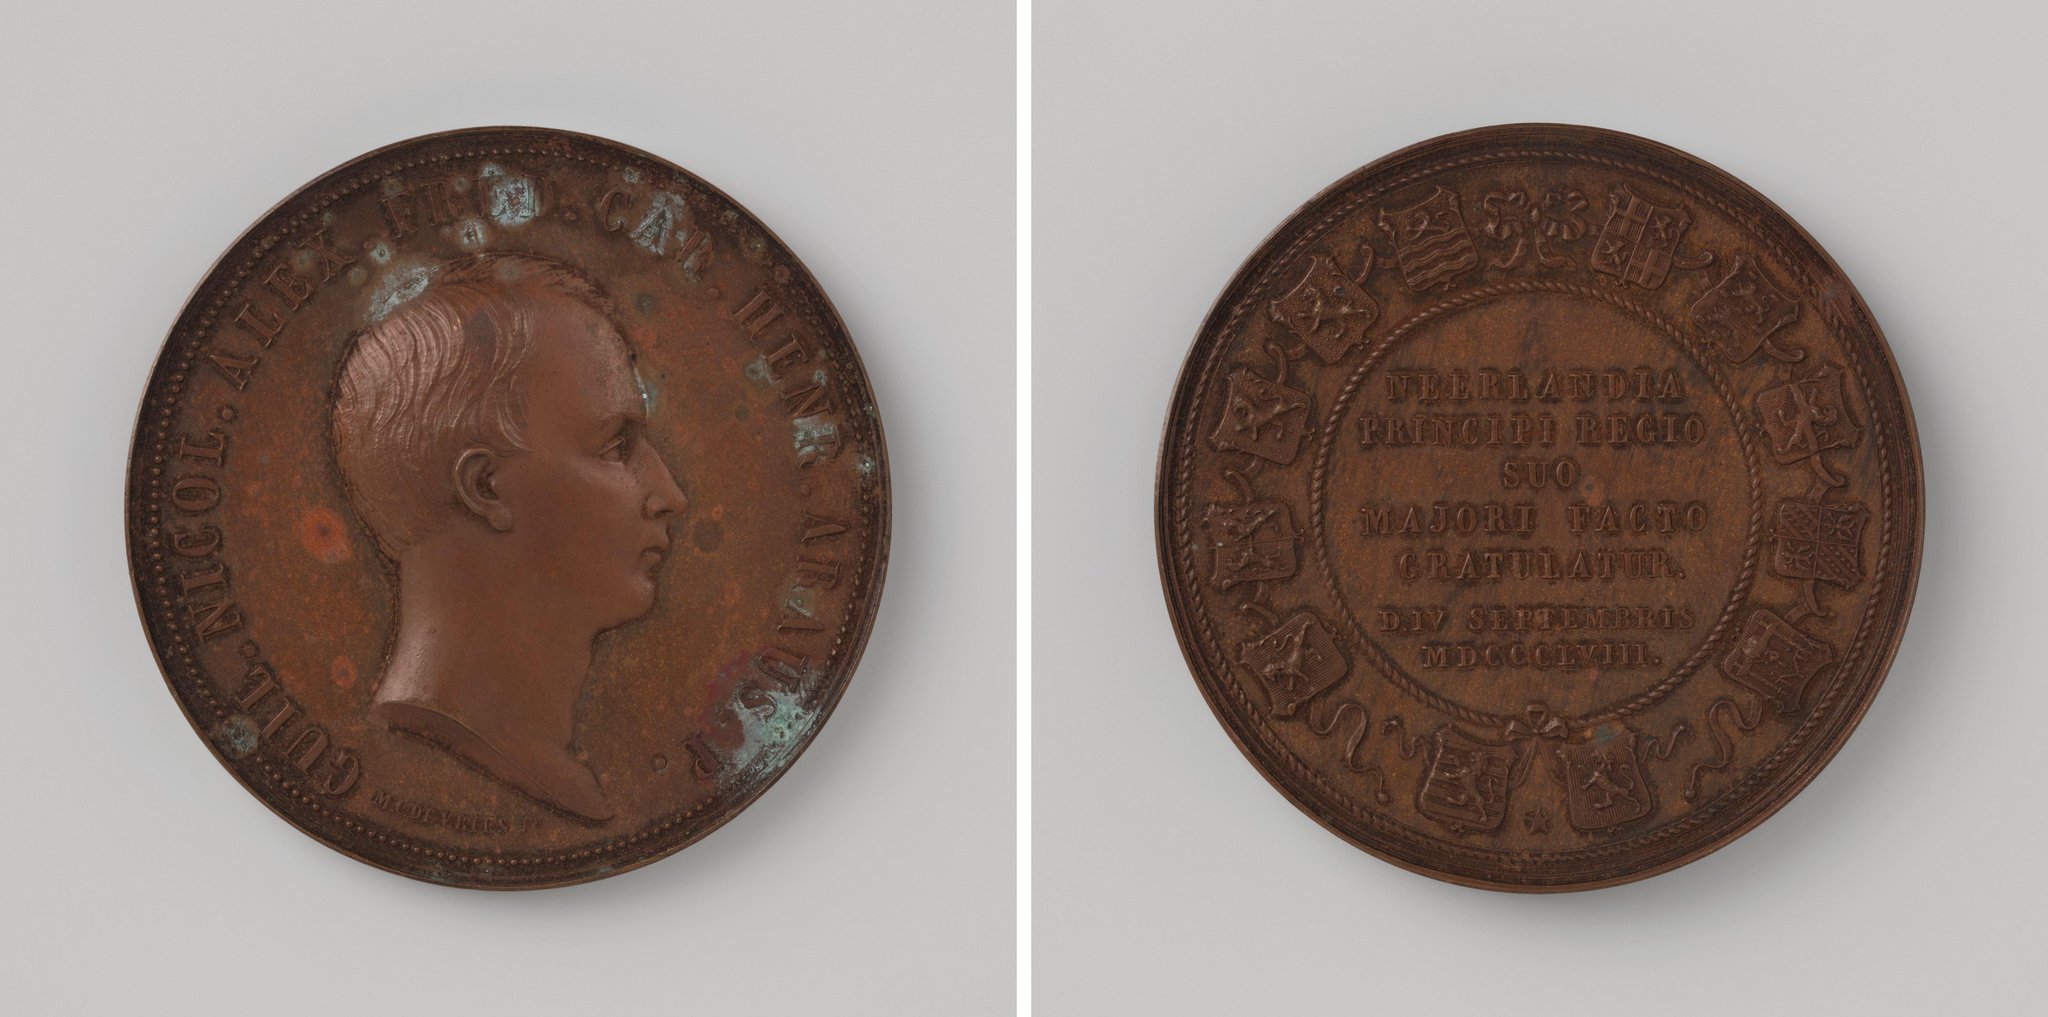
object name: history medal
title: Meerderjarigheid van kroonprins Willem Nicolaas Alexander 1858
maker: moses cohen de vries junior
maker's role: diamantslijper, graveur, medailleur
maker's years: 1807-1883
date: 1858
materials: bronze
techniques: striking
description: Bronzen penning, op de voorzijde het portret van de Kroonprins naar rechts met omschrift, op de keerzijde zeven regels tekst binnen een kring van provinciale wapenschilden met onderaan die van Limburg en Luxemburg waartussen een vijfpuntige ster.